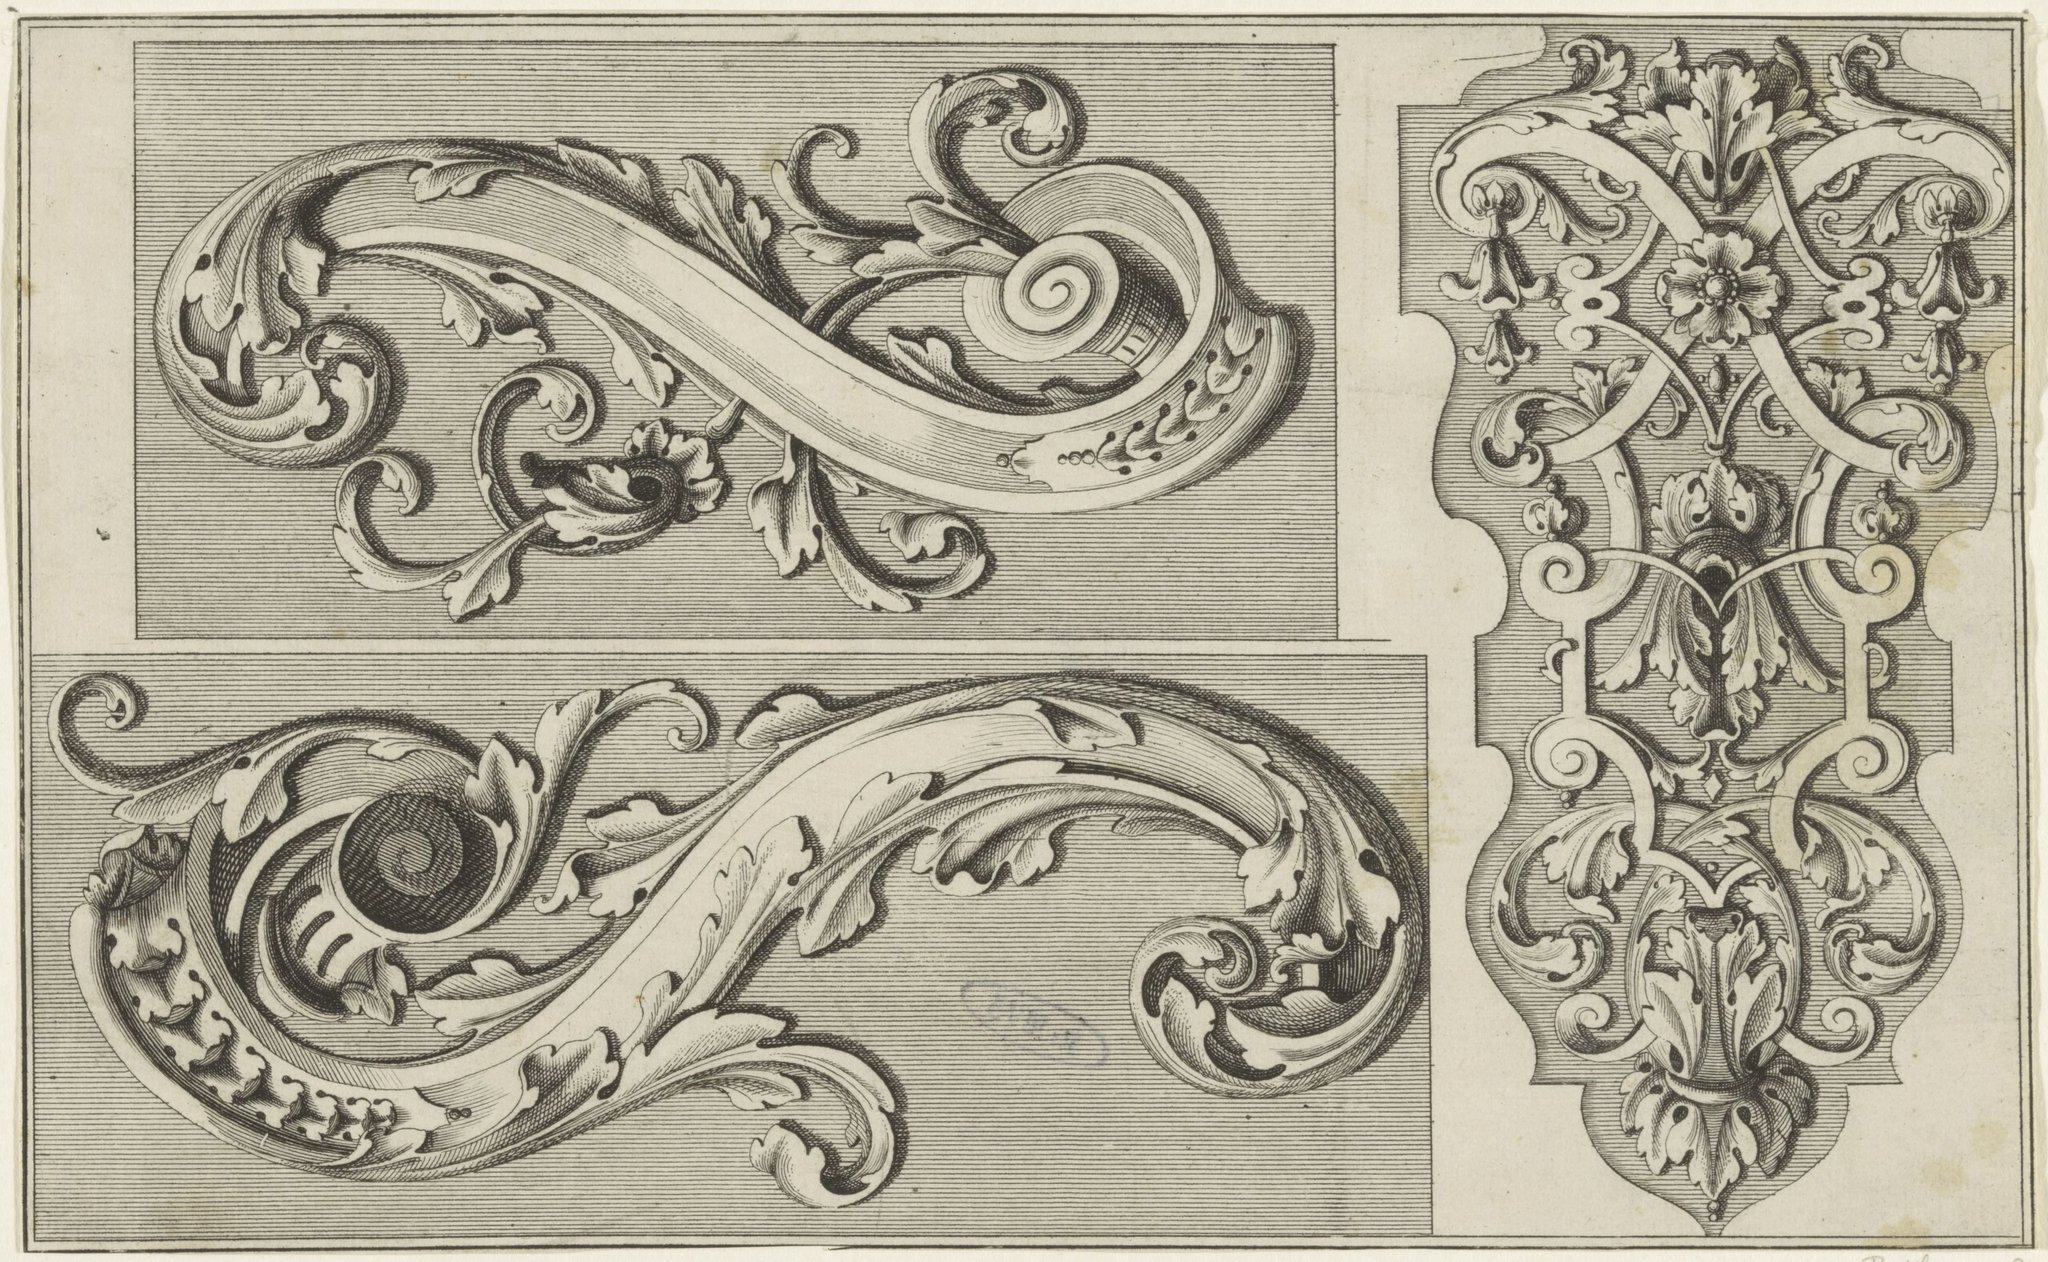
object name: ornament print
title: Voorbeelden van bladsoorten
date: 1726-1734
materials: paper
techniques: etching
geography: nuremberg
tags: palmette ~ ornament, ornament ~ arabesque, 'laub- und bandelwerk' ~ ornament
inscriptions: collector's mark: Lugt 2228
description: Twee arabesken met acanthusbladeren en een arabesk met bladeren, bloemen en vlechtwerk.